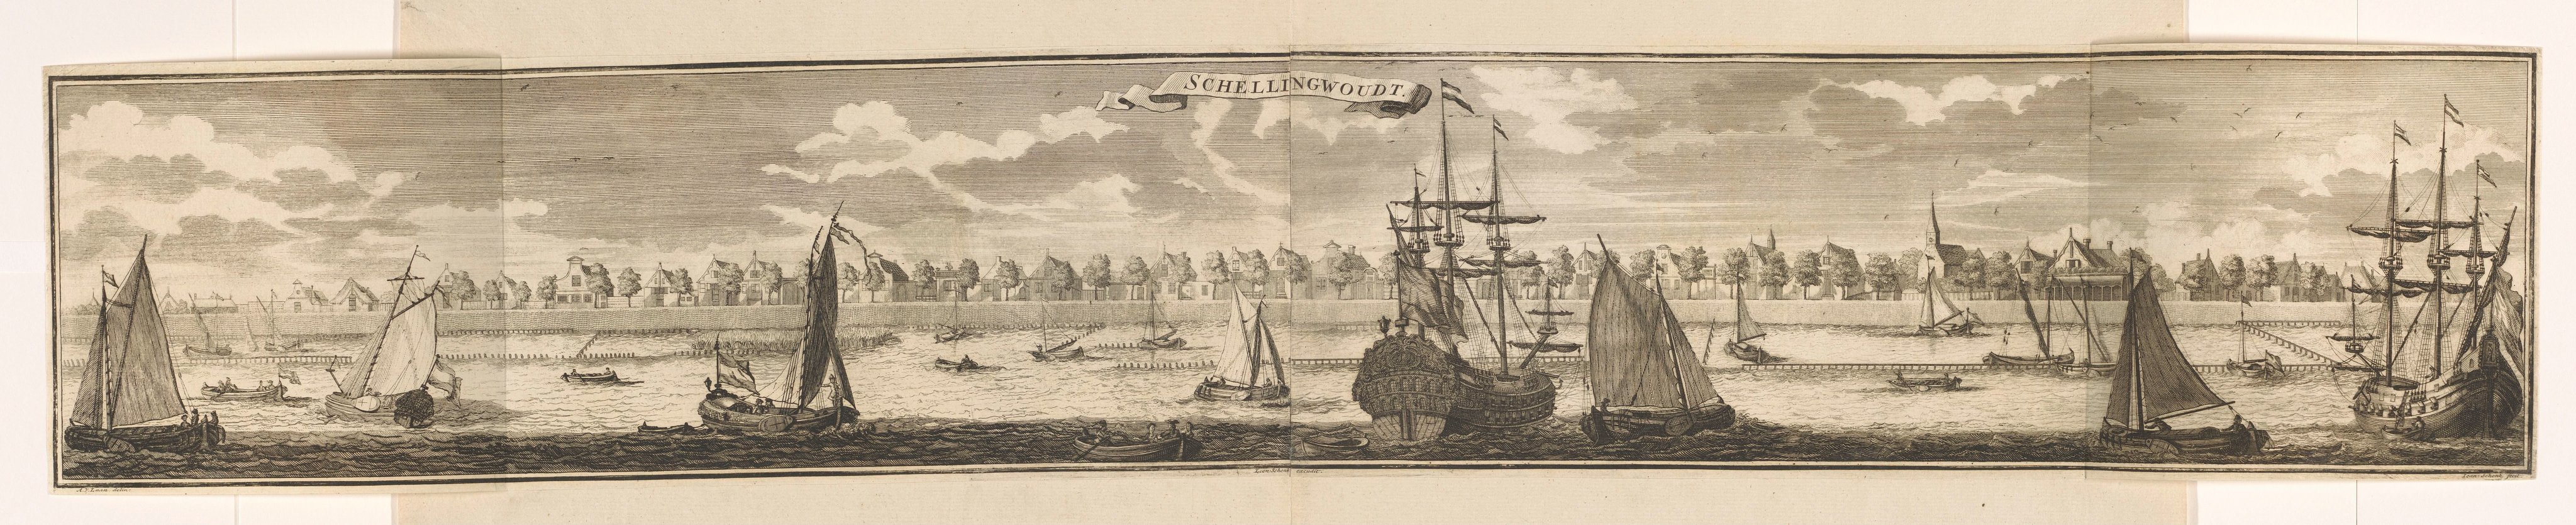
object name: print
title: Gezicht op Schellingwoude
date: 1731-1767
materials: paper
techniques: engraving, etching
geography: amsterdam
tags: city-view in general; 'veduta', sea (seascape)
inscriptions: collector's mark: Lugt 195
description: Gezicht op het dorp Schellingwoude, gezien vanaf het water. Op de voorgrond schepen, op de achtergrond het dorp.